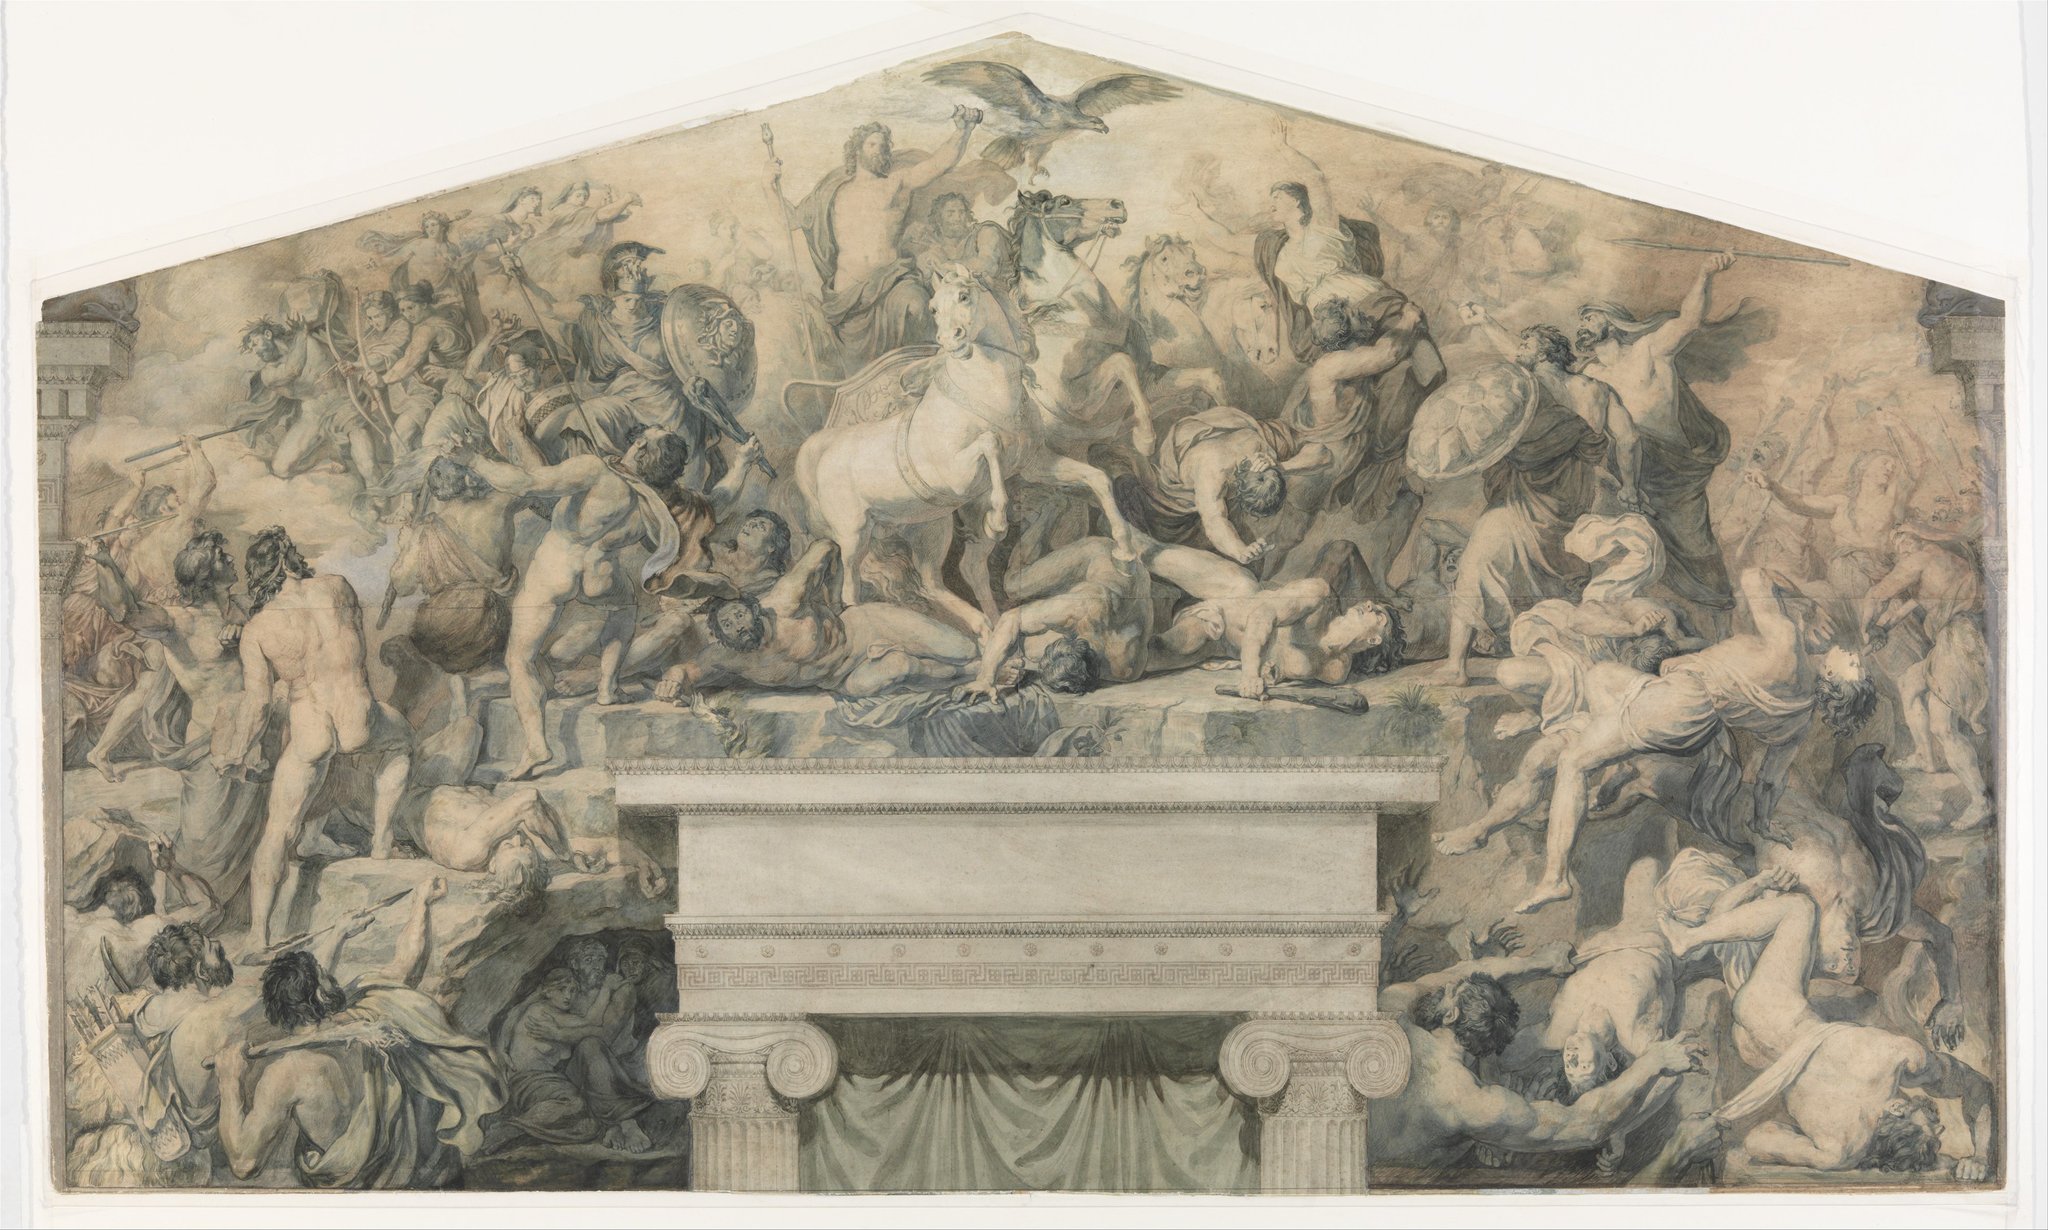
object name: drawing ornament architecture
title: Design for a Mural with the Battle between the Gods of Olympus and the Giants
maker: paul chenavard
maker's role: artist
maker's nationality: french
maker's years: 1808-1895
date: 1840-1880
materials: ink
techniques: brush, pen, wash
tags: battles,male nudes,horses